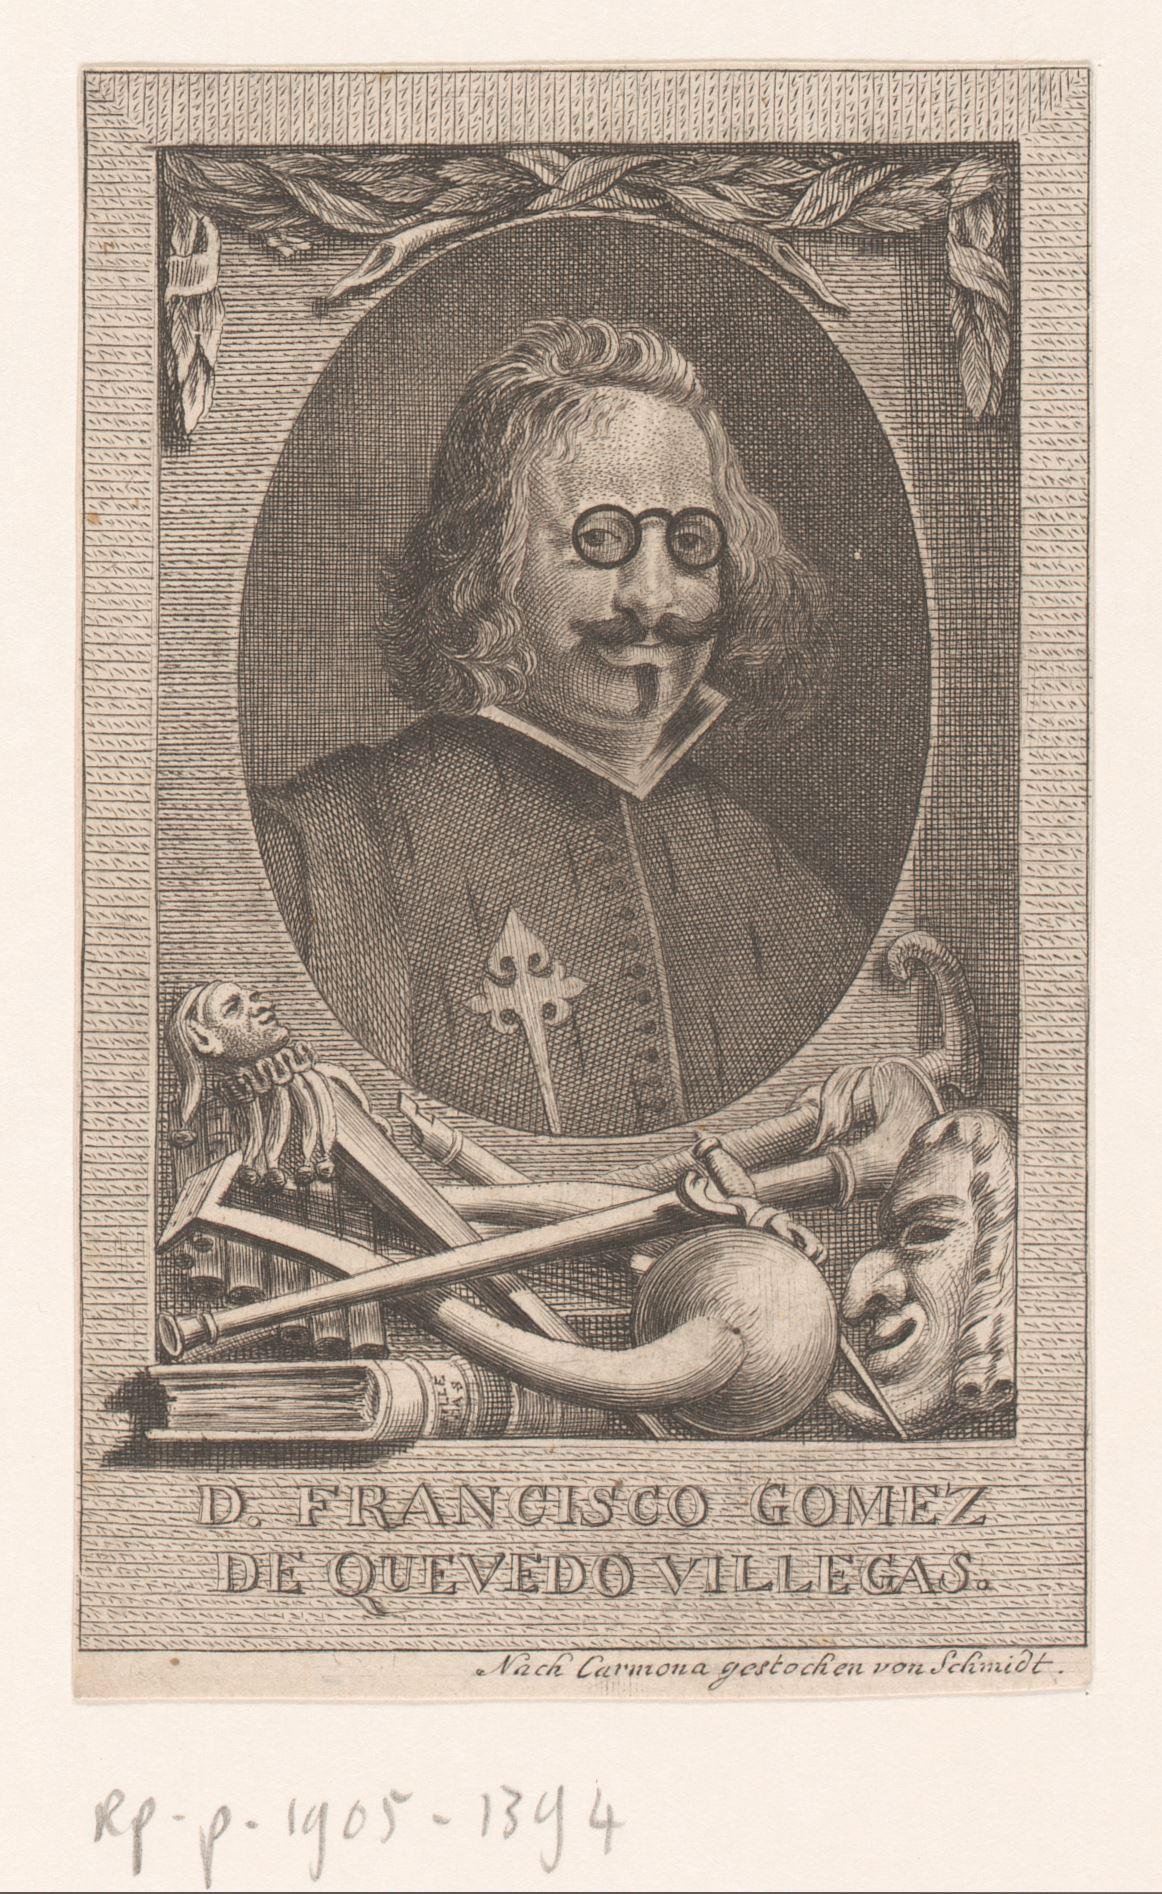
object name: print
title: Portret van Francisco Gómez de Quevedo y Santibáñez Villegas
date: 1750-1811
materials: paper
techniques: etching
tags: historical persons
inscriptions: collector's mark: Lugt 2228